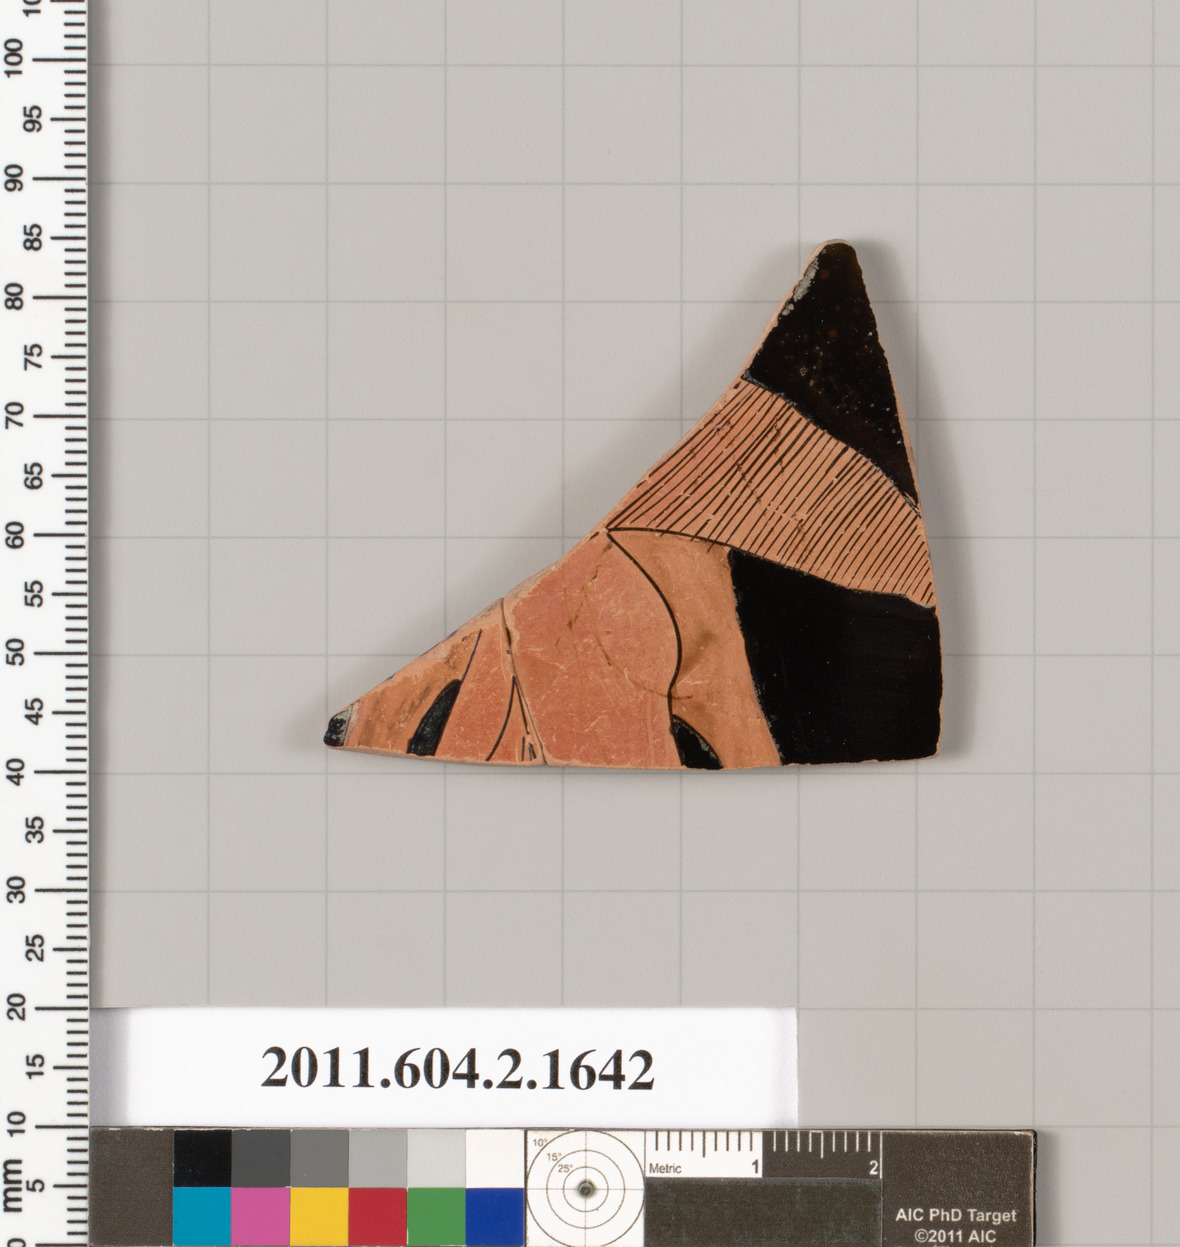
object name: skyphos fragment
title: Terracotta fragment of a skyphos (deep drinking cup)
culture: greek, attic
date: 480-470 BCE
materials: terracotta